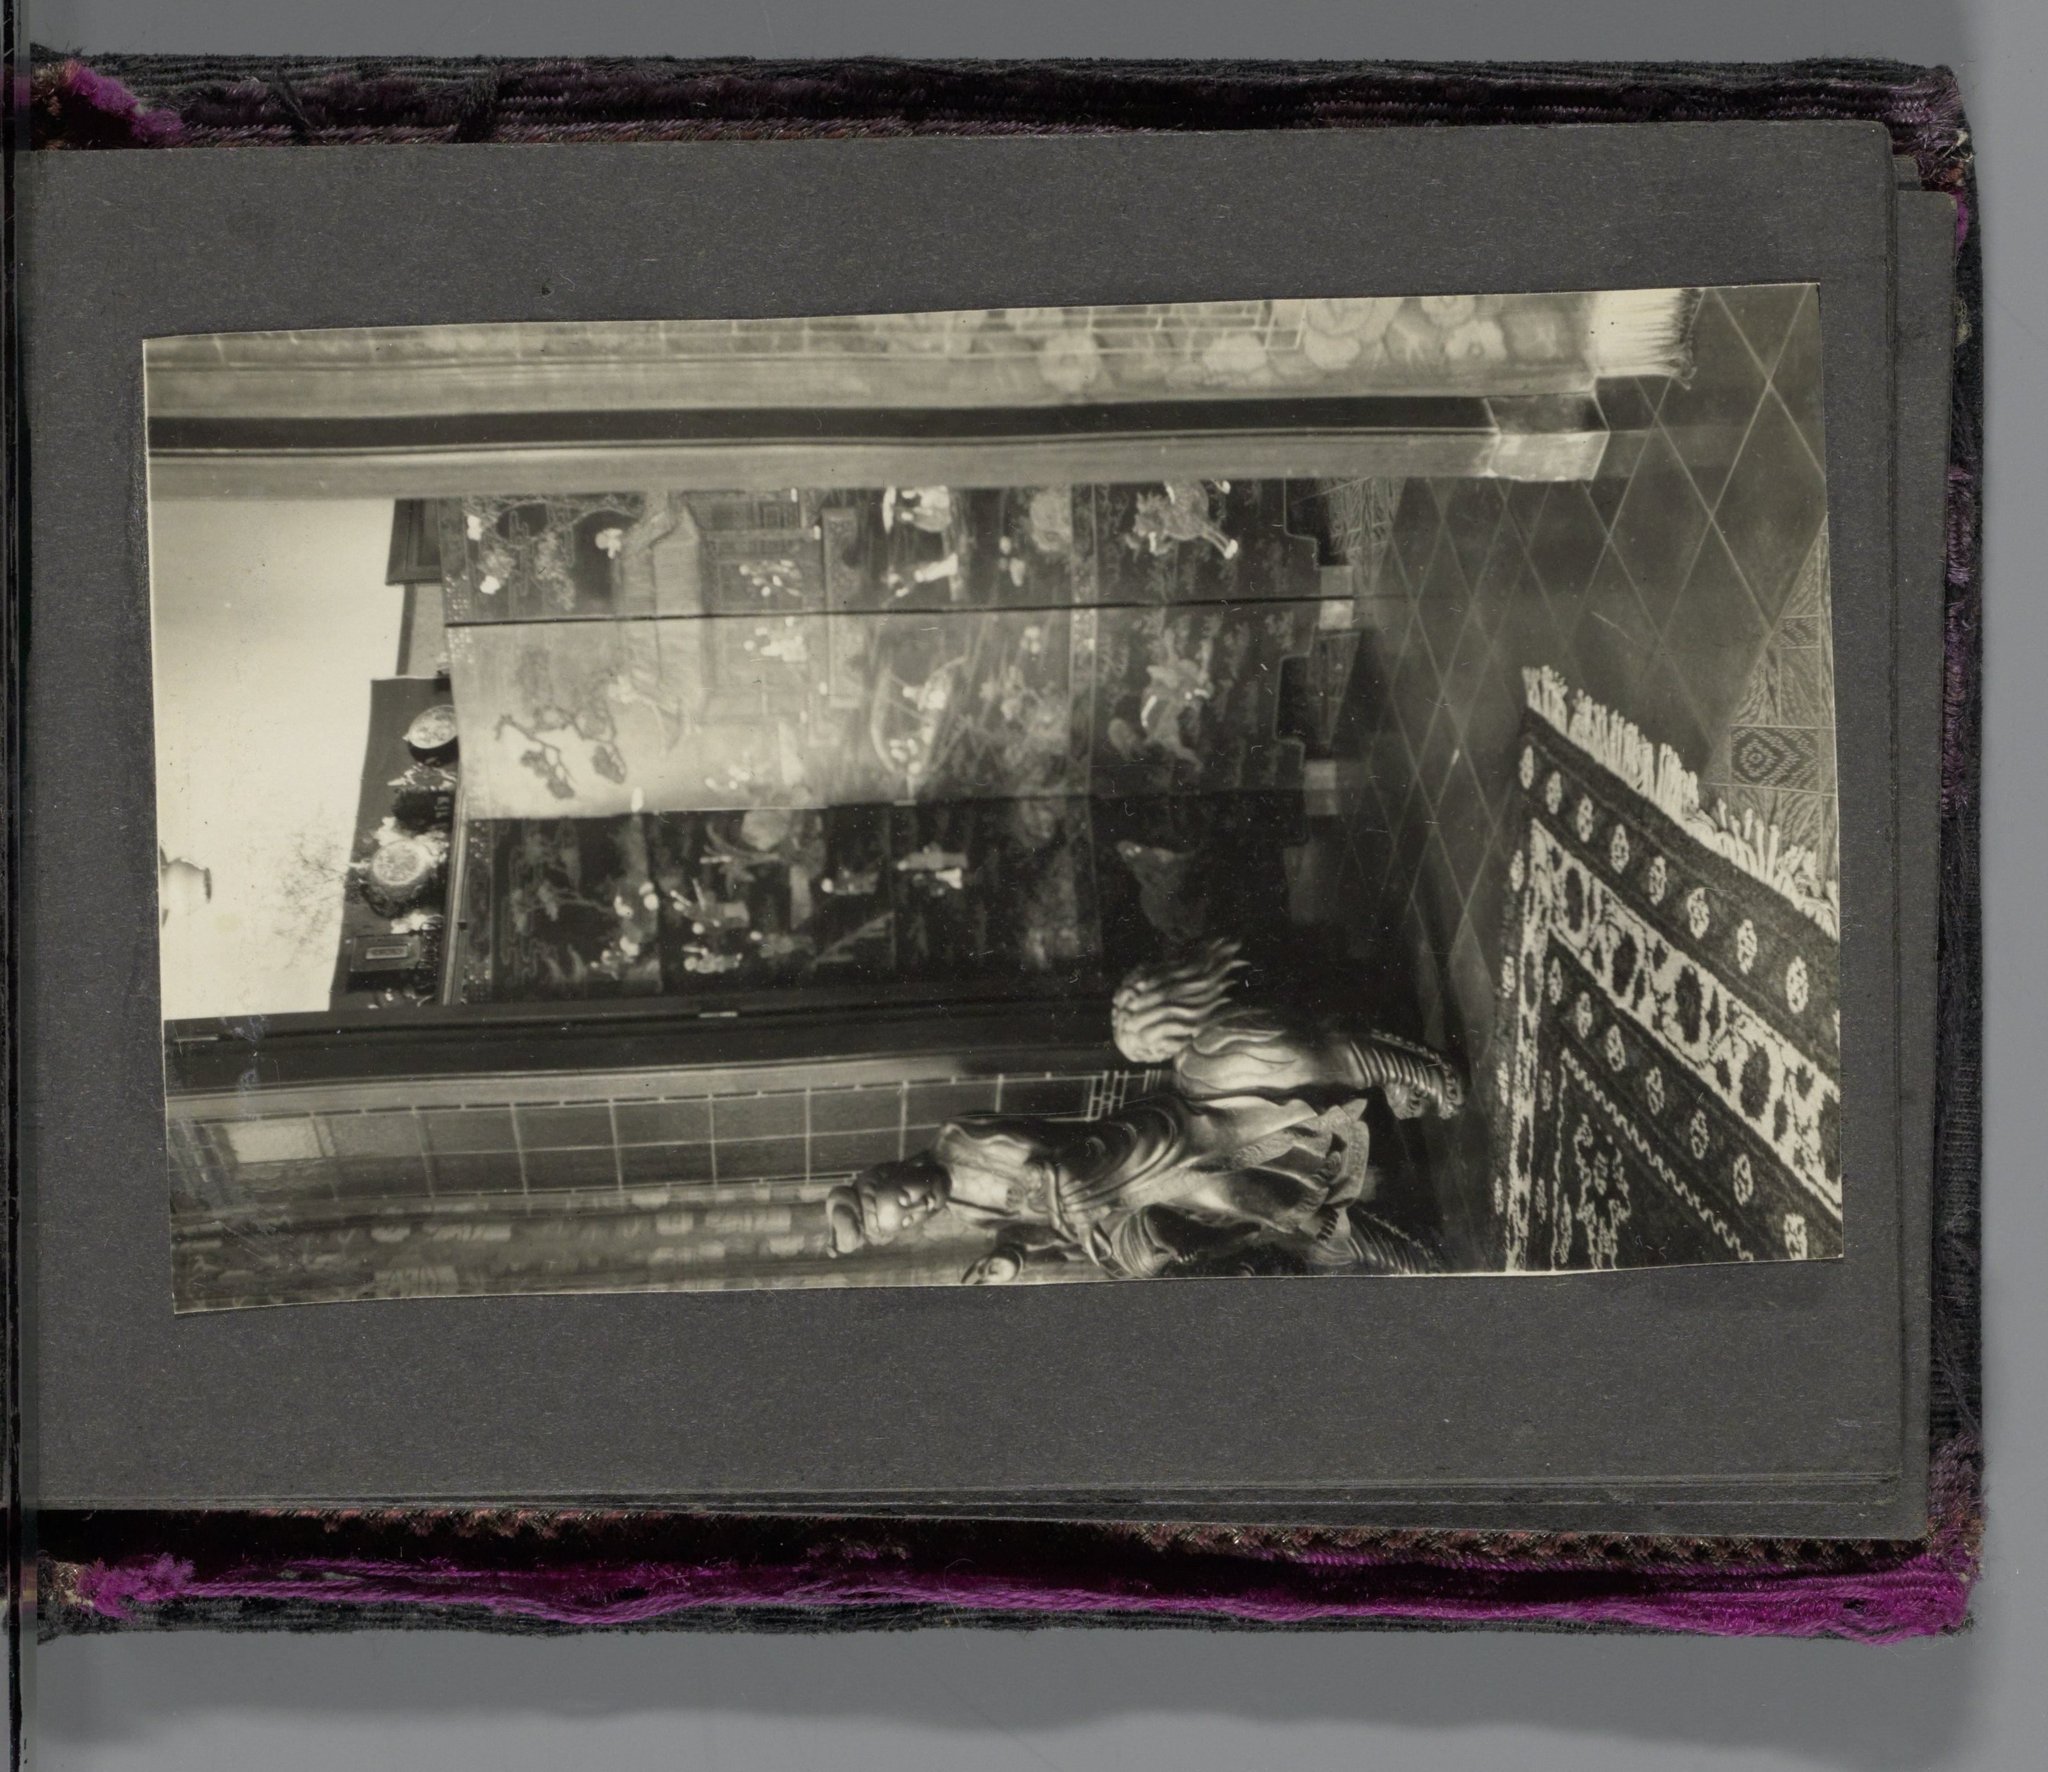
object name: photograph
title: Chinese kast met beeldjes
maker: elsa silberstein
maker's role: amateurfotograaf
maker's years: -2006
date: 1935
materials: photographic support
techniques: gelatin silver print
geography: bandung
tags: elsa silberstein, interior of the house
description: Een Chinese hoekkast met enkele beeldjes. In het woonhuis van Elsa Silberstein en haar man, thesaurier-generaal in Bandung in 1935. Schilderijtjes aan de muur. Onderdeel van het fotoalbum met zwart-wit foto's van het interieur van het huis van de familie Silberstein in Bandung in Nederlands-Indië.